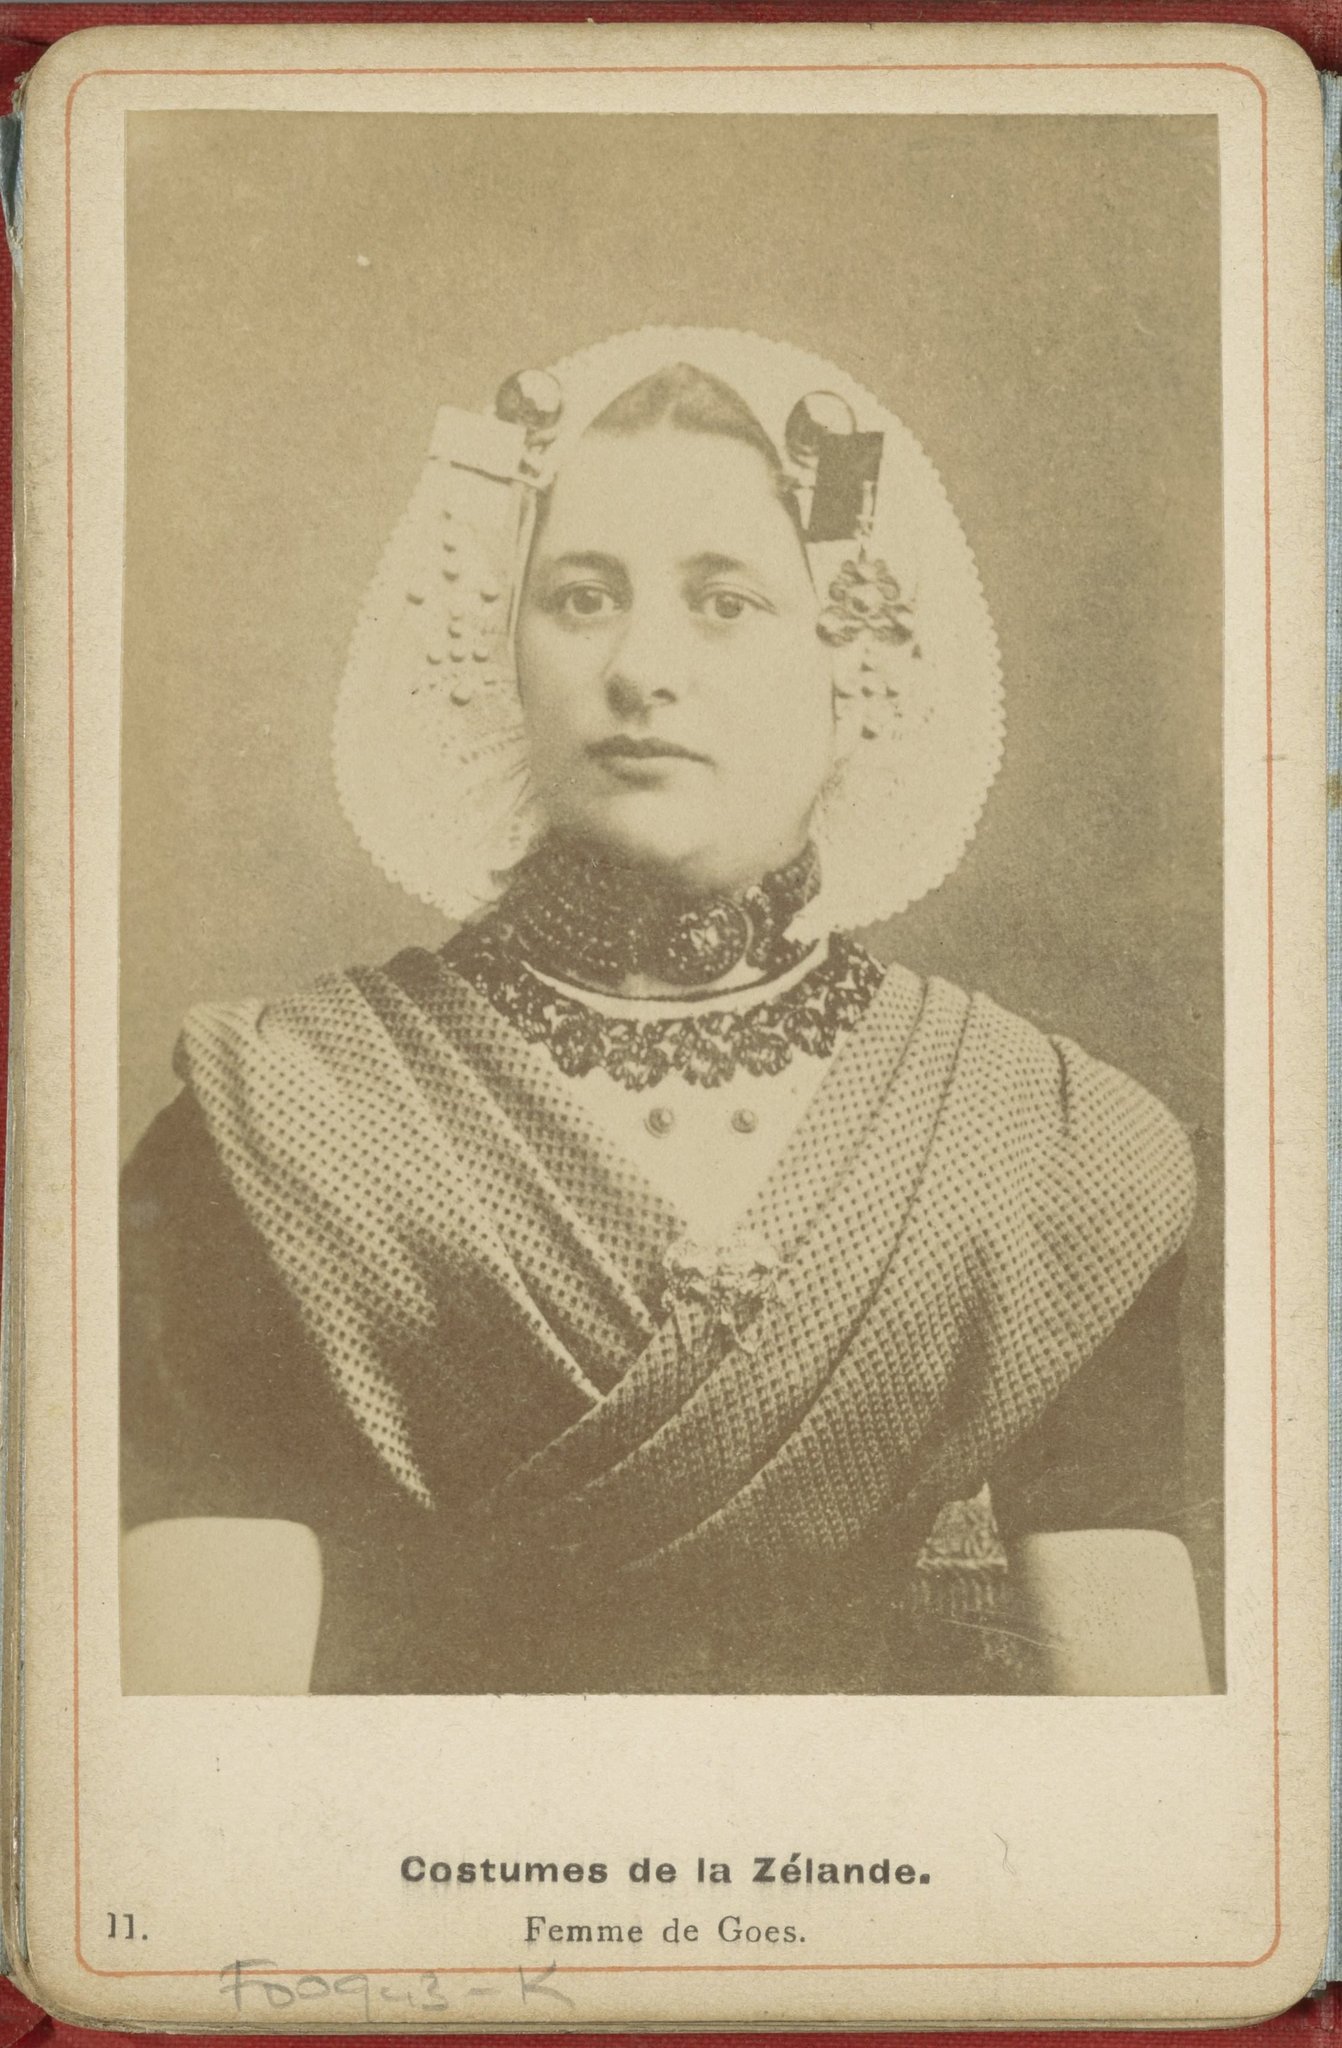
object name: photograph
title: Femme de Goes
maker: Anonymous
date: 1870-1910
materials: cardboard, photographic support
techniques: albumen print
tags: folk costume, regional costume (+ women's clothes)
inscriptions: number: ‘11’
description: Onderdeel van Leporelloalbum met Zeeuwse klederdrachten.